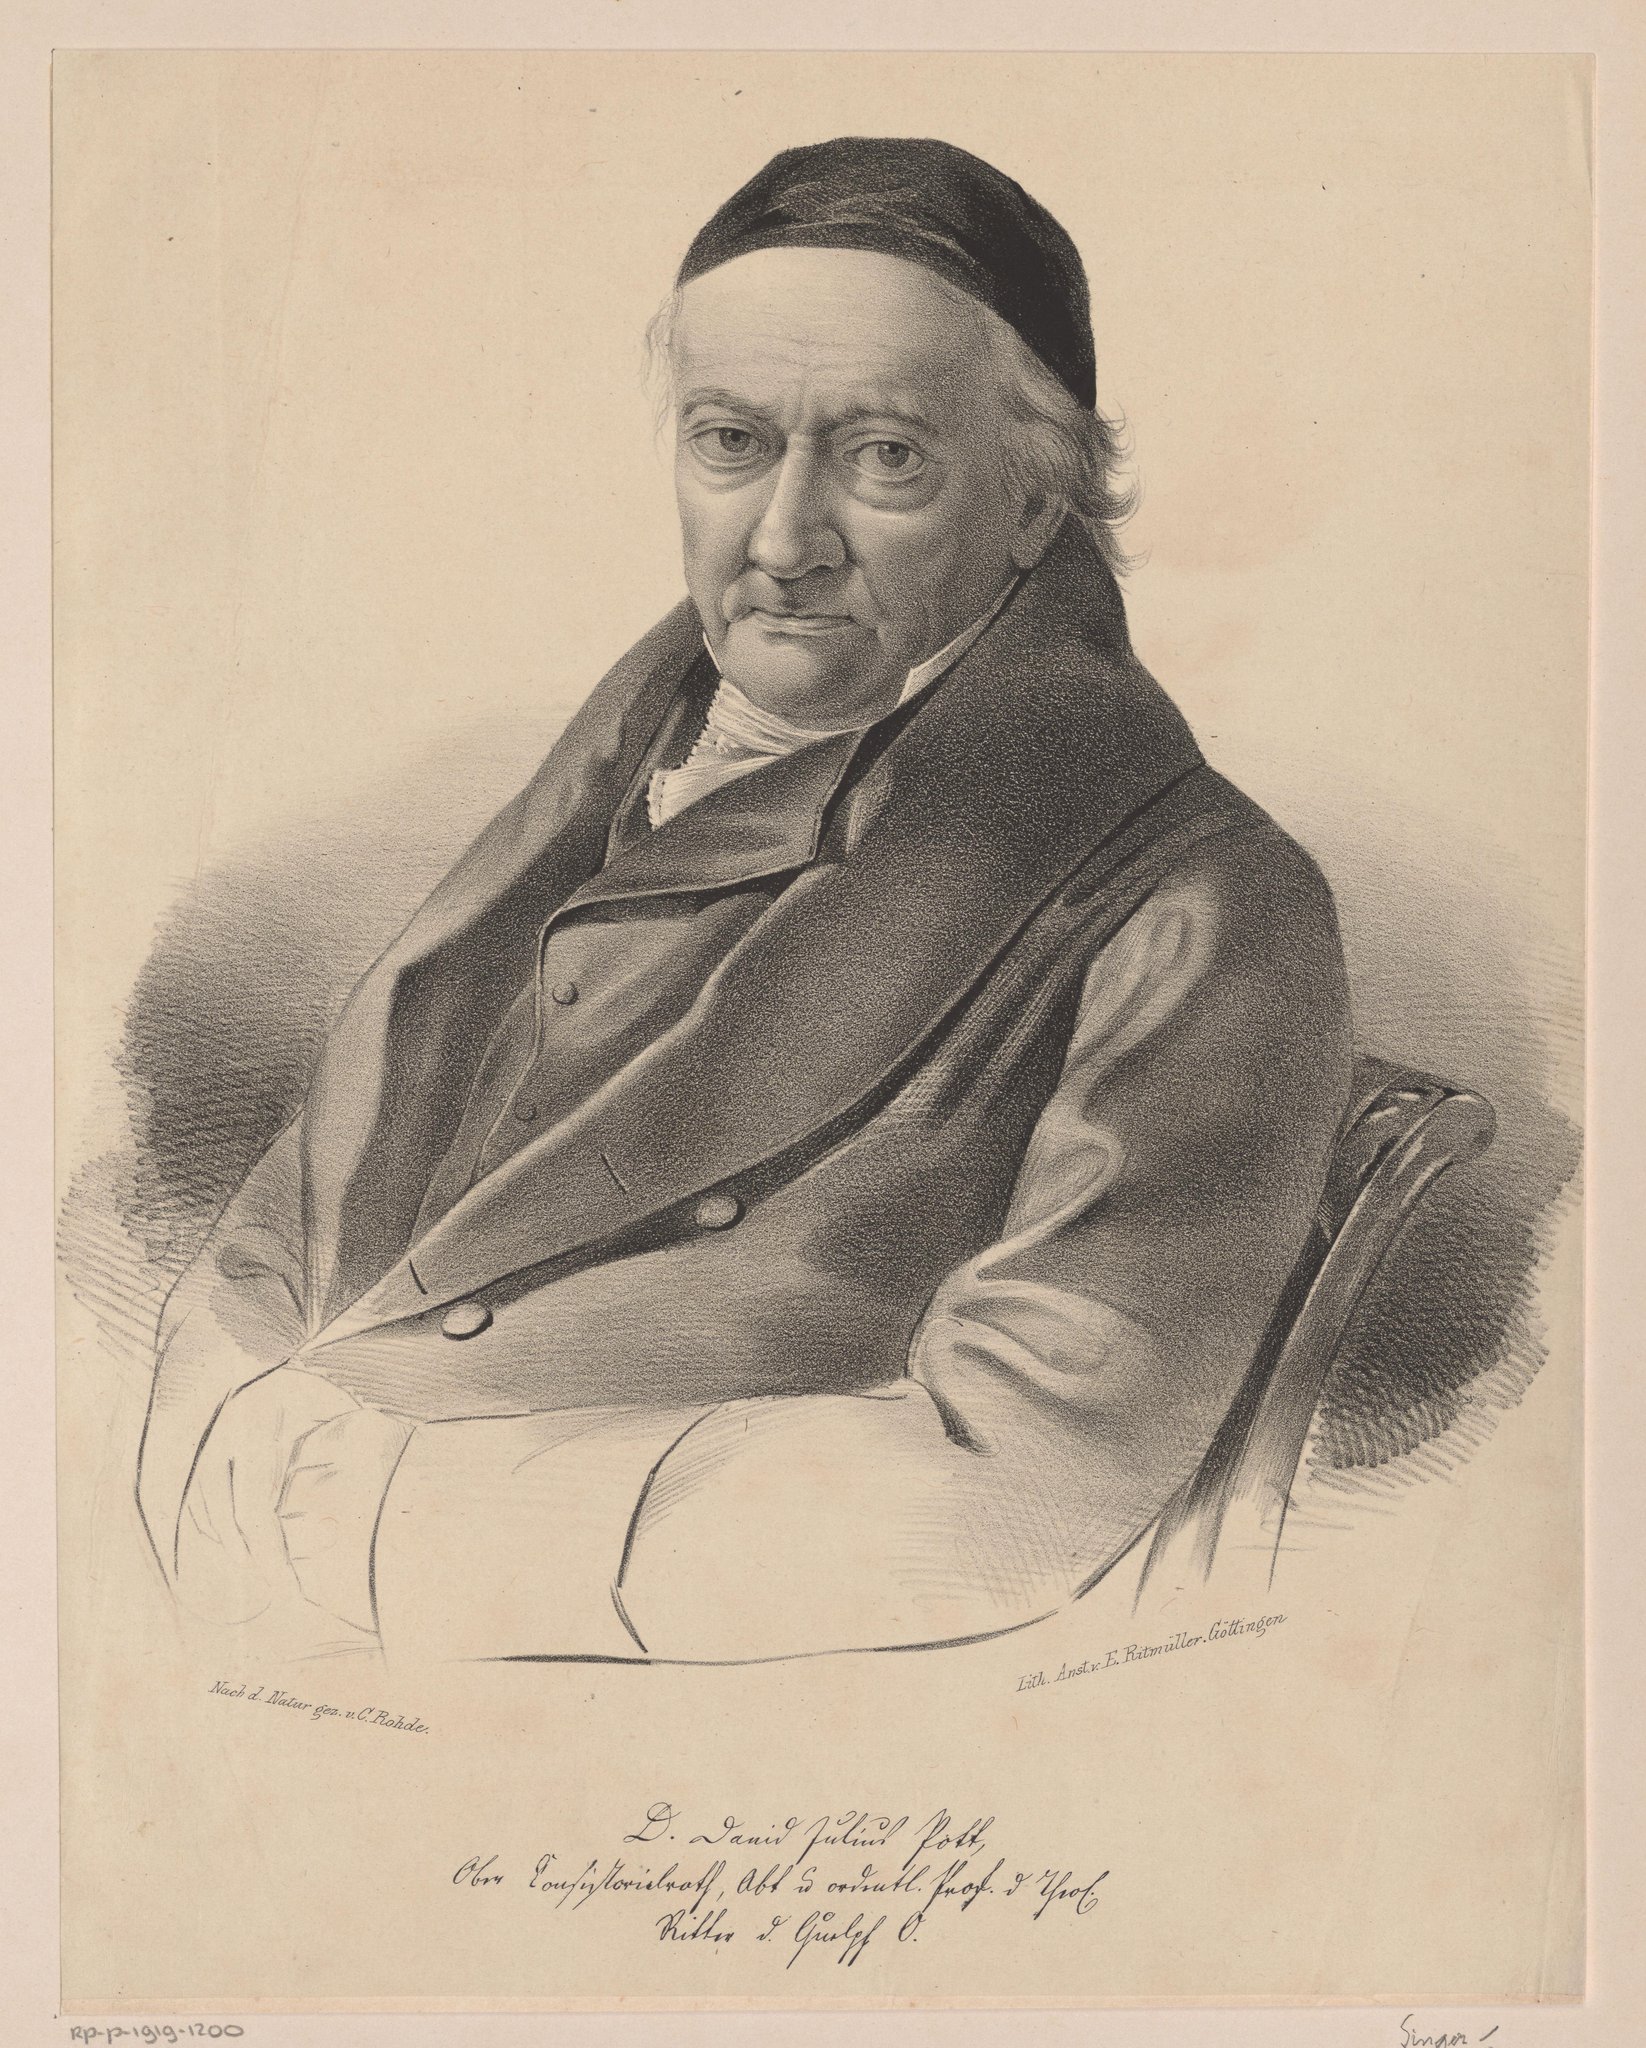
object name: print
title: Portret van David Julius Pott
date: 1816-1869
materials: paper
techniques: lithograph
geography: gottingen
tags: theologian, historical persons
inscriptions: collector's mark: Lugt 2228